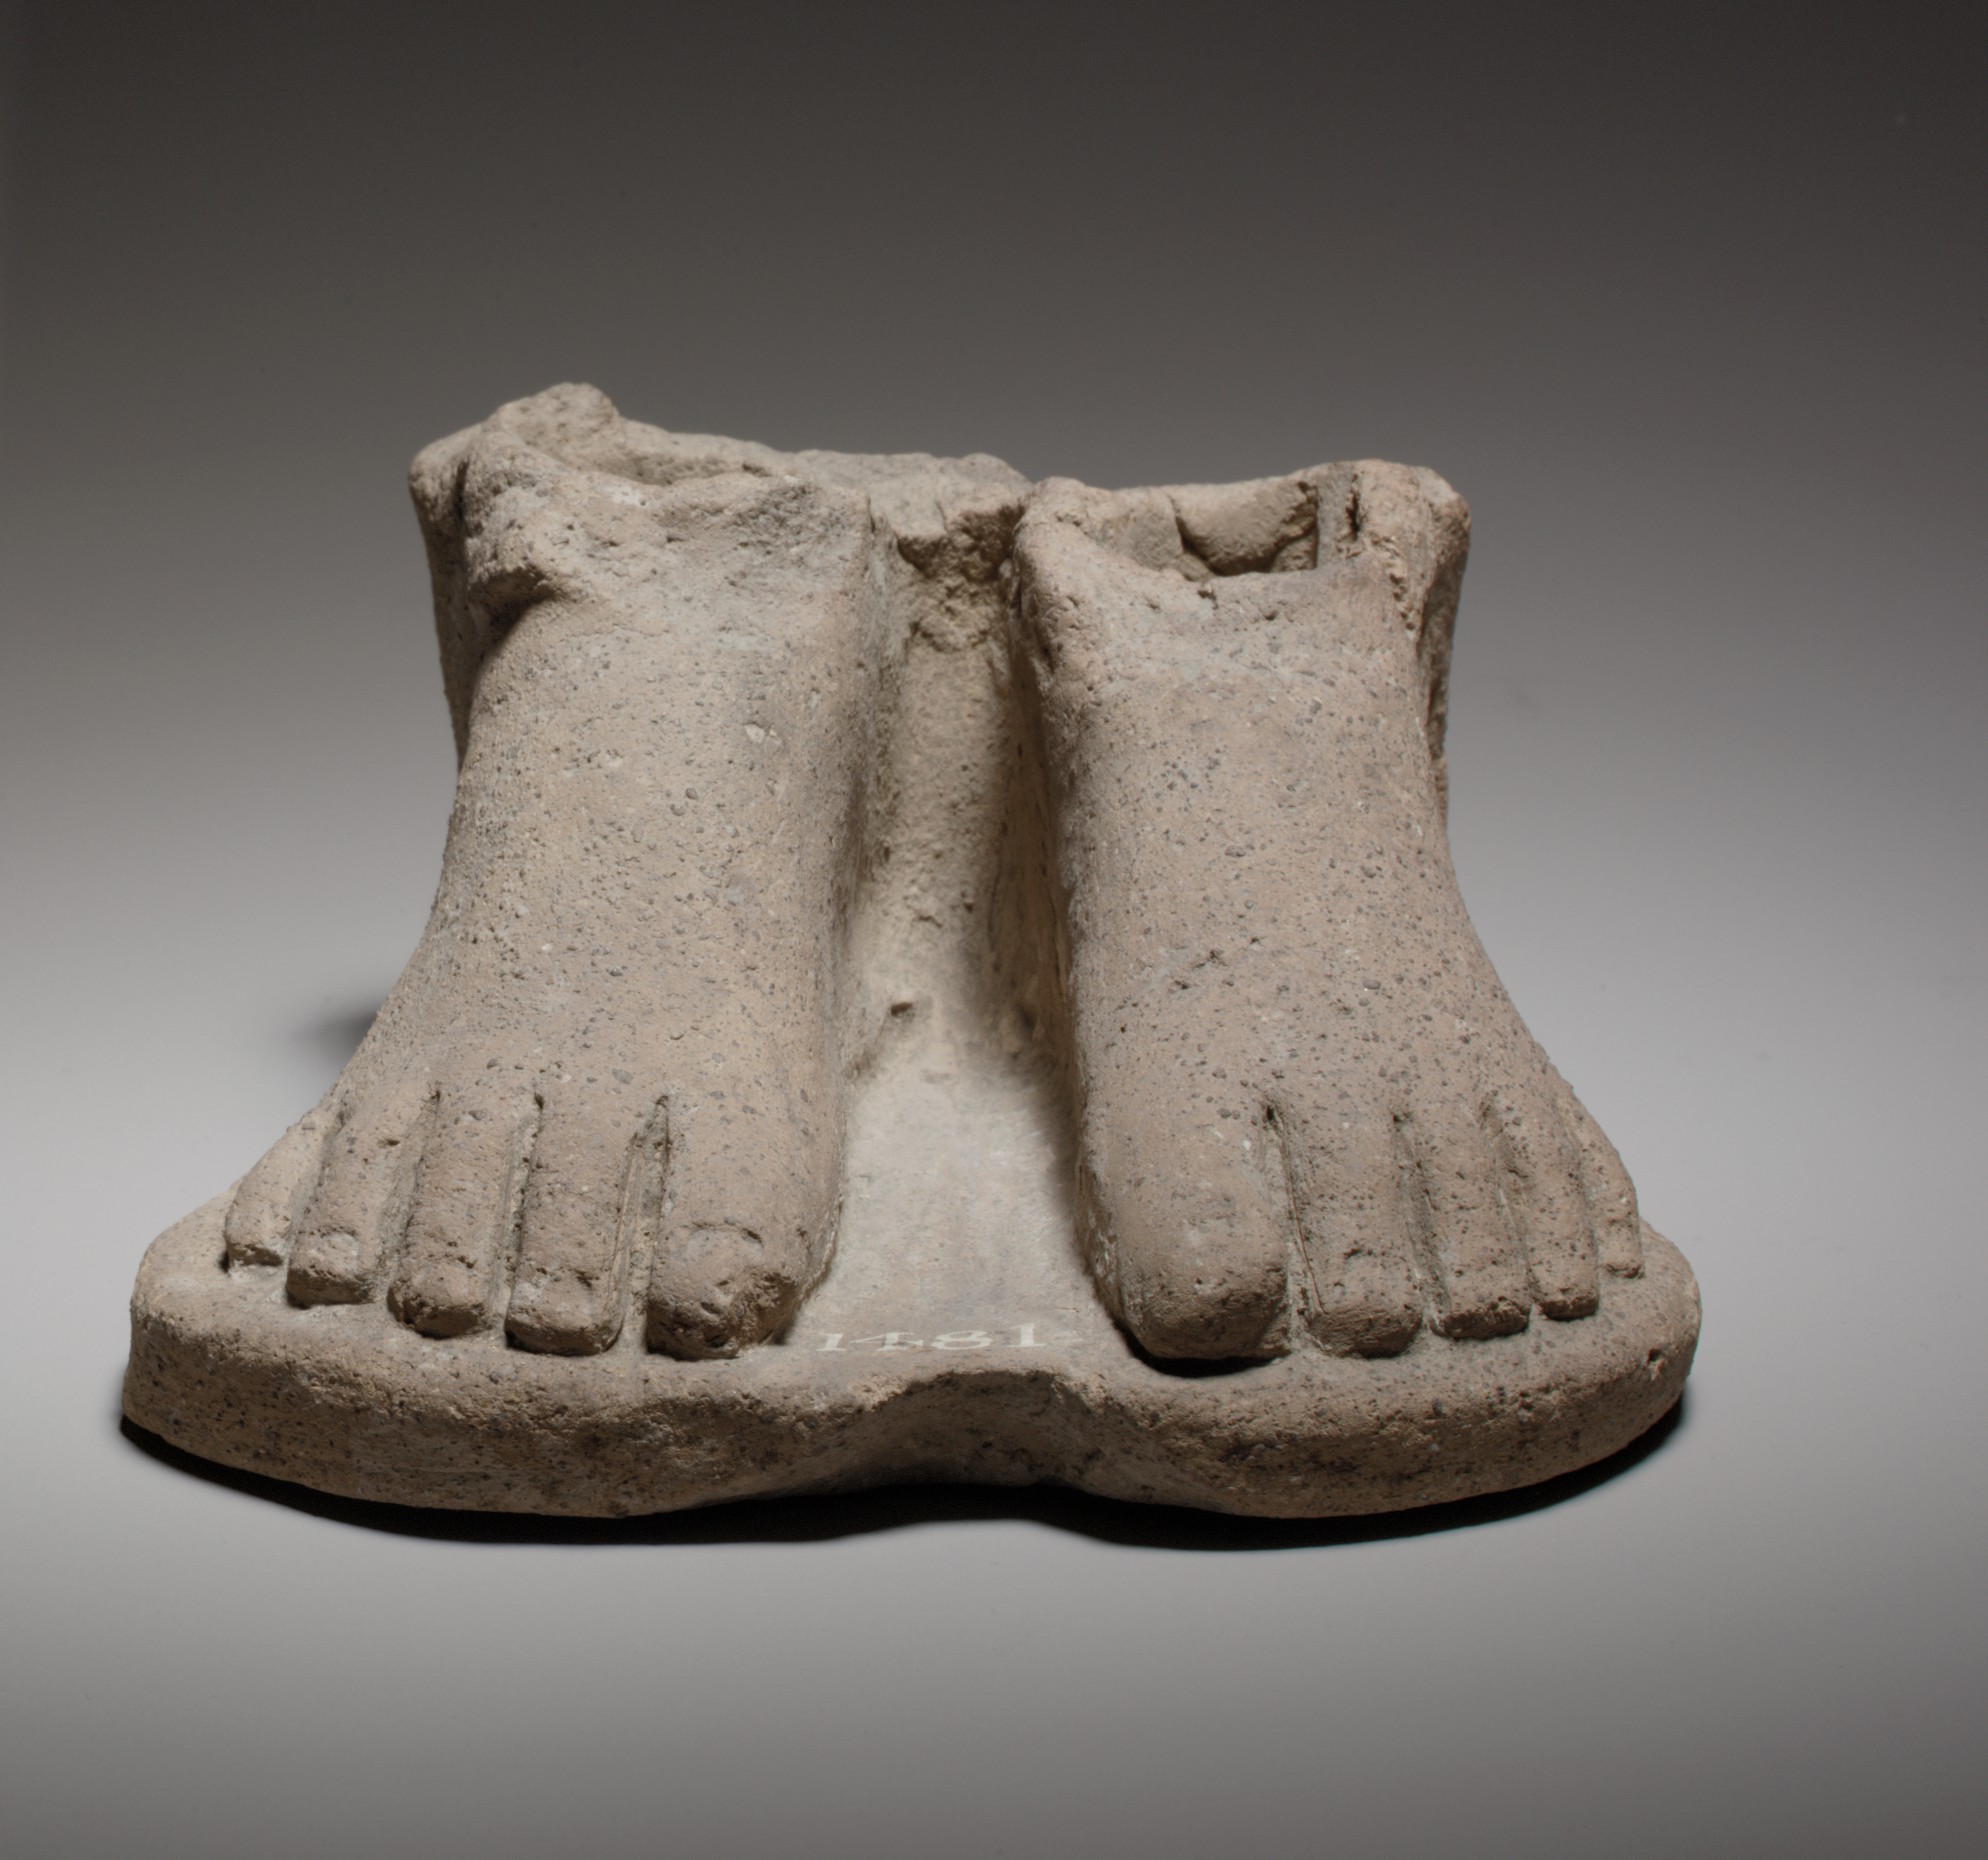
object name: foot on plinth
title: Feet on a plinth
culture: cypriot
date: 480-400 BCE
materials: terracotta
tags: feet